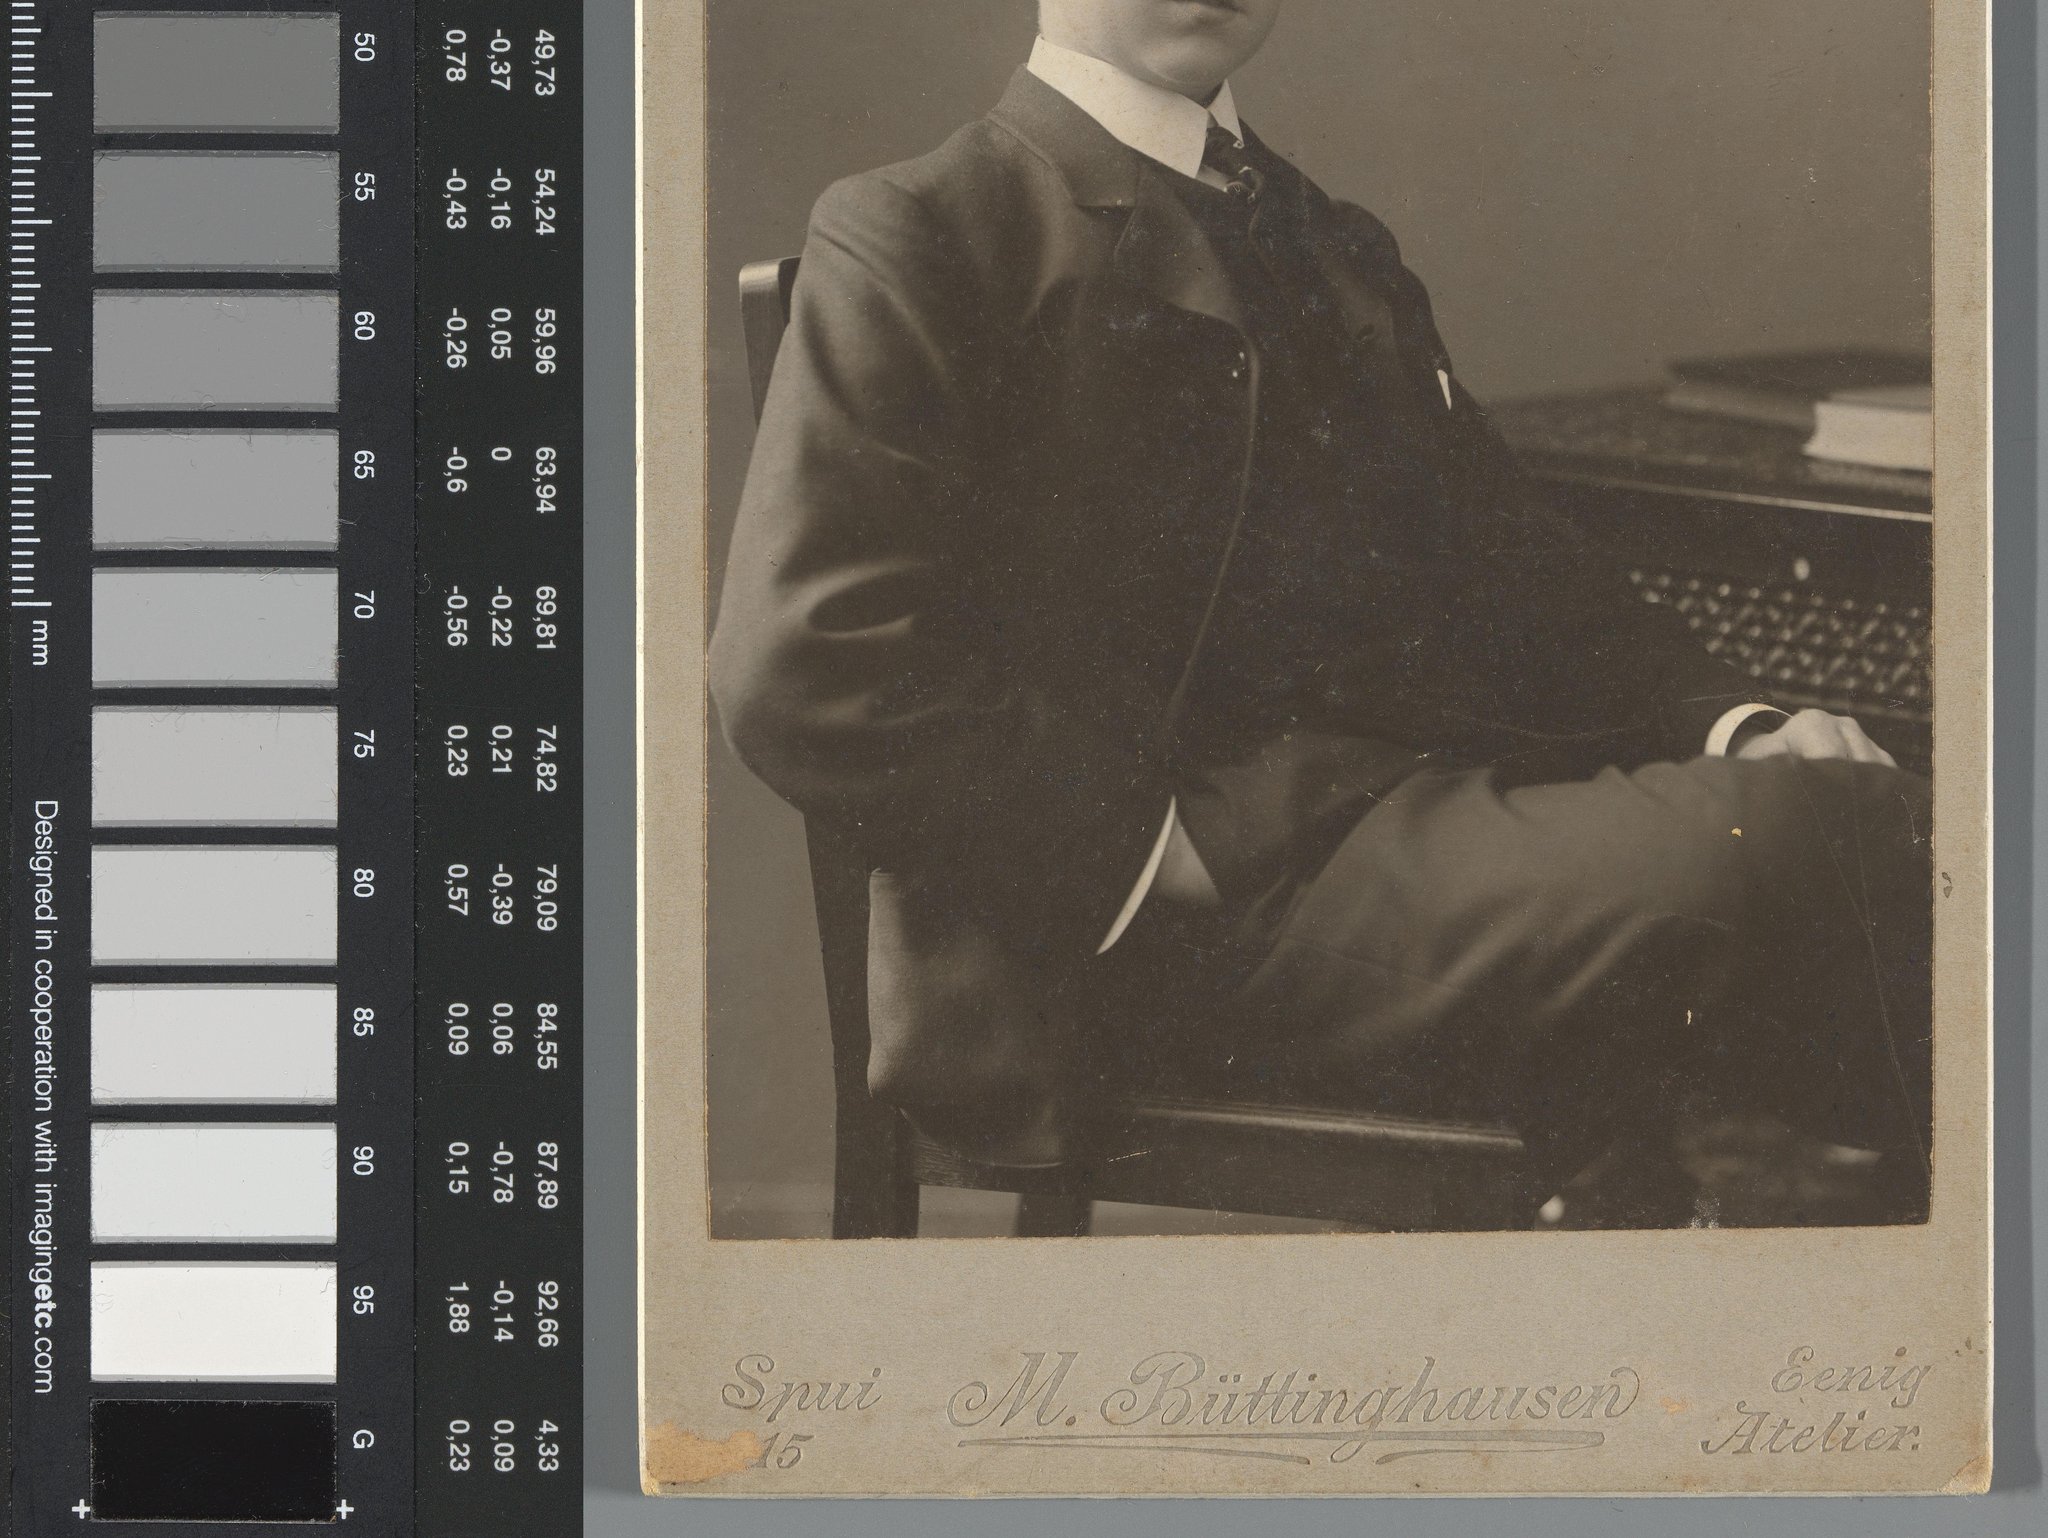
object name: cabinet photograph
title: Portret van de zoon van Piet Onnen en Emilie van den Berg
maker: max büttinghausen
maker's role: fotograaf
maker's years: 1847-1906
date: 1900-1915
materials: cardboard, photographic support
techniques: albumen print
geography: spui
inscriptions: inscription: ‘Spui / 15 / M. Büttinghausen / Eenig / Atelier.’